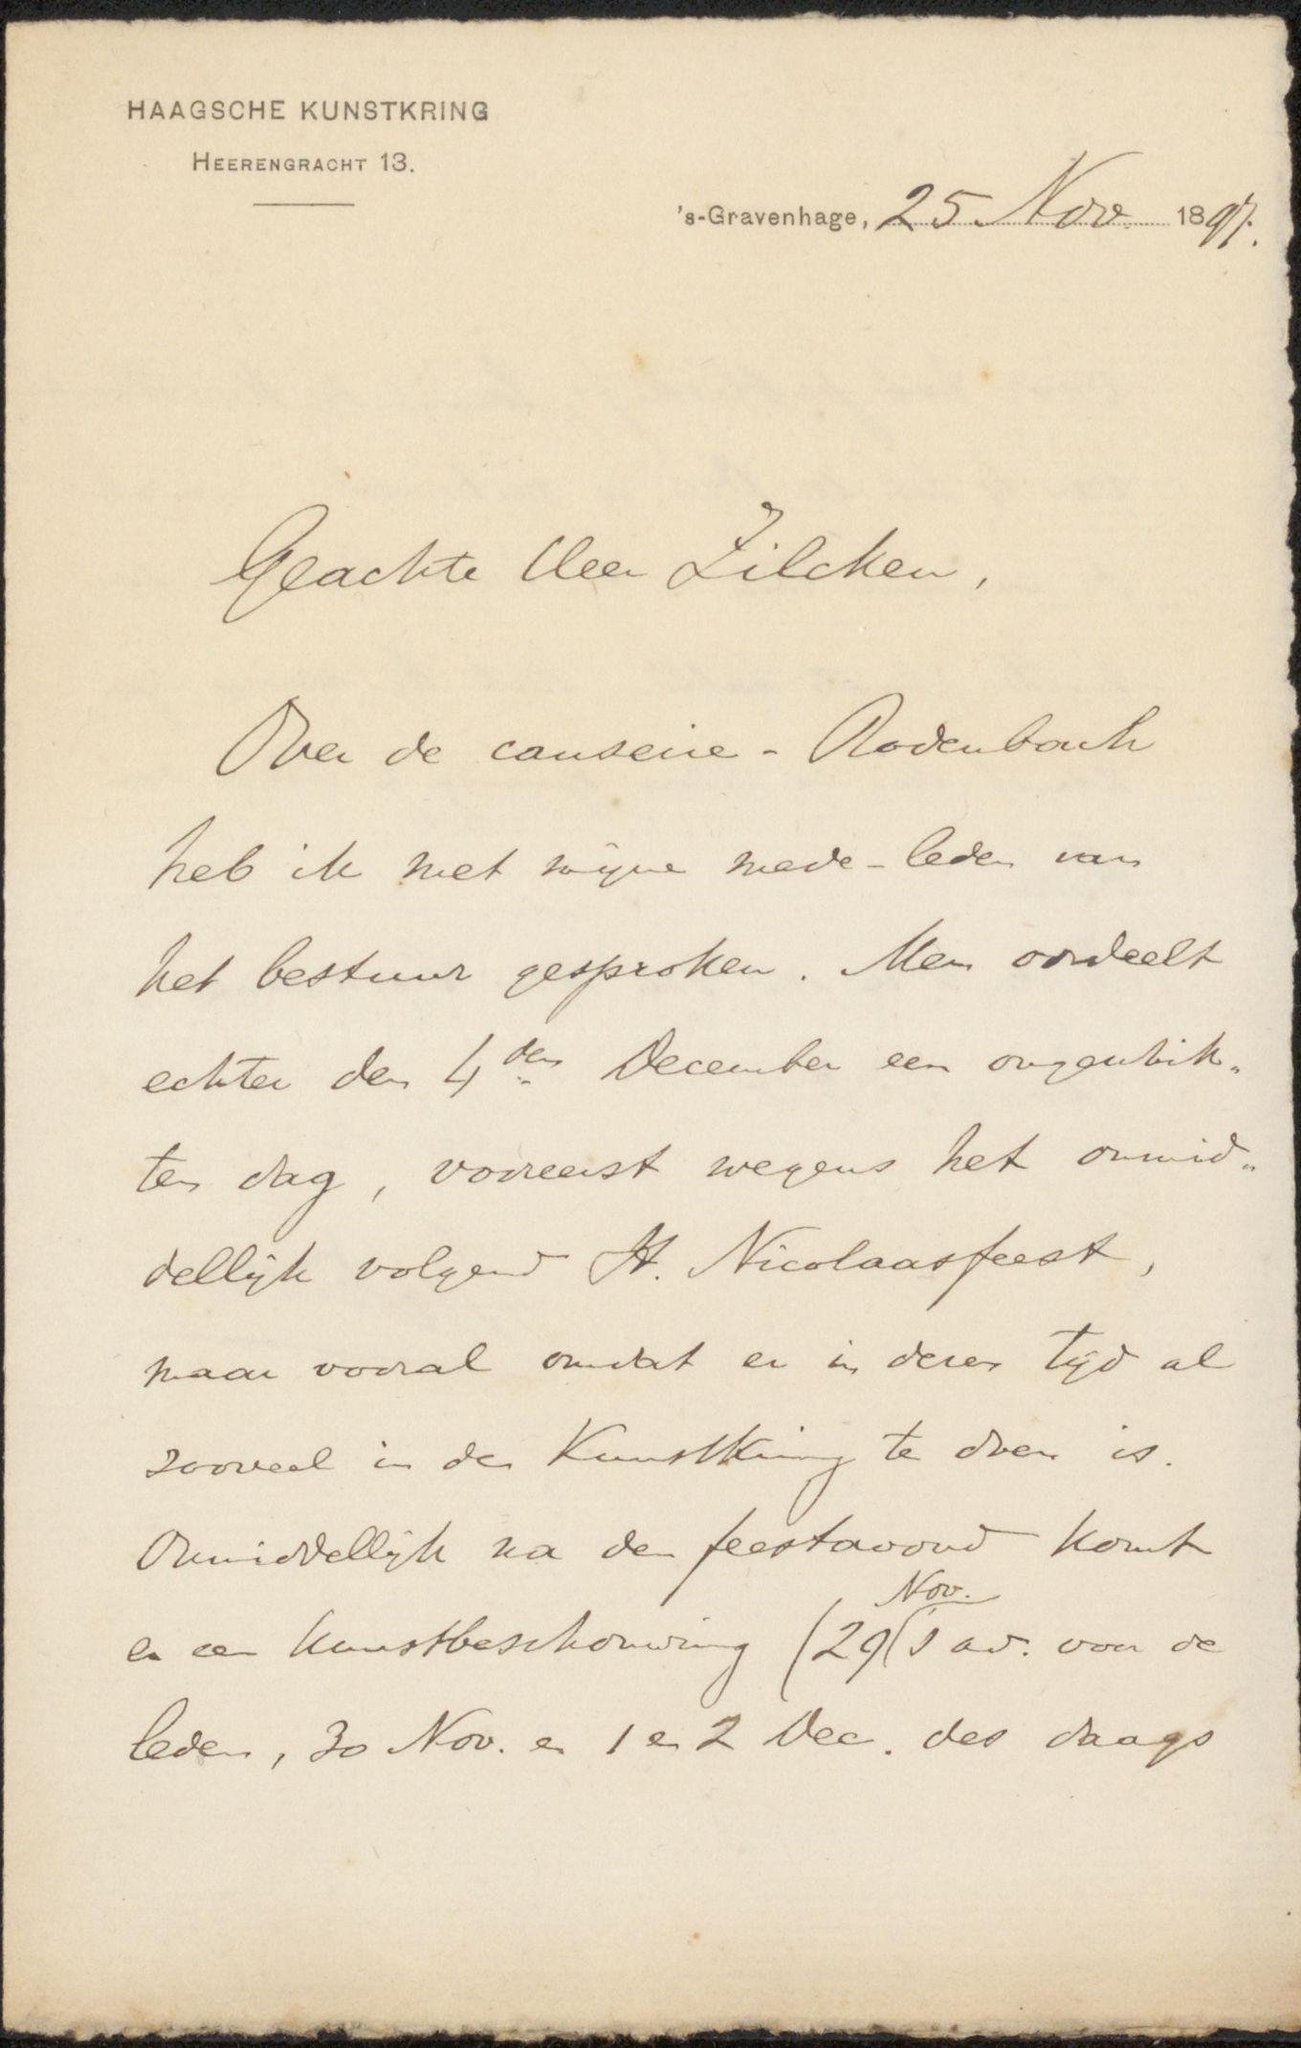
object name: letter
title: Brief aan Philip Zilcken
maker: frans willem jan george snijder van wissenkerke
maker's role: jurist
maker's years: 1856-1940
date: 1897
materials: ink, paper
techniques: pen, printing, writing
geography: the hague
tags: georges rodenbach, painter, draughtsman, philip zilcken, criticizing and discussing art, art criticism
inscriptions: watermark, collector's mark: ‘RPK’